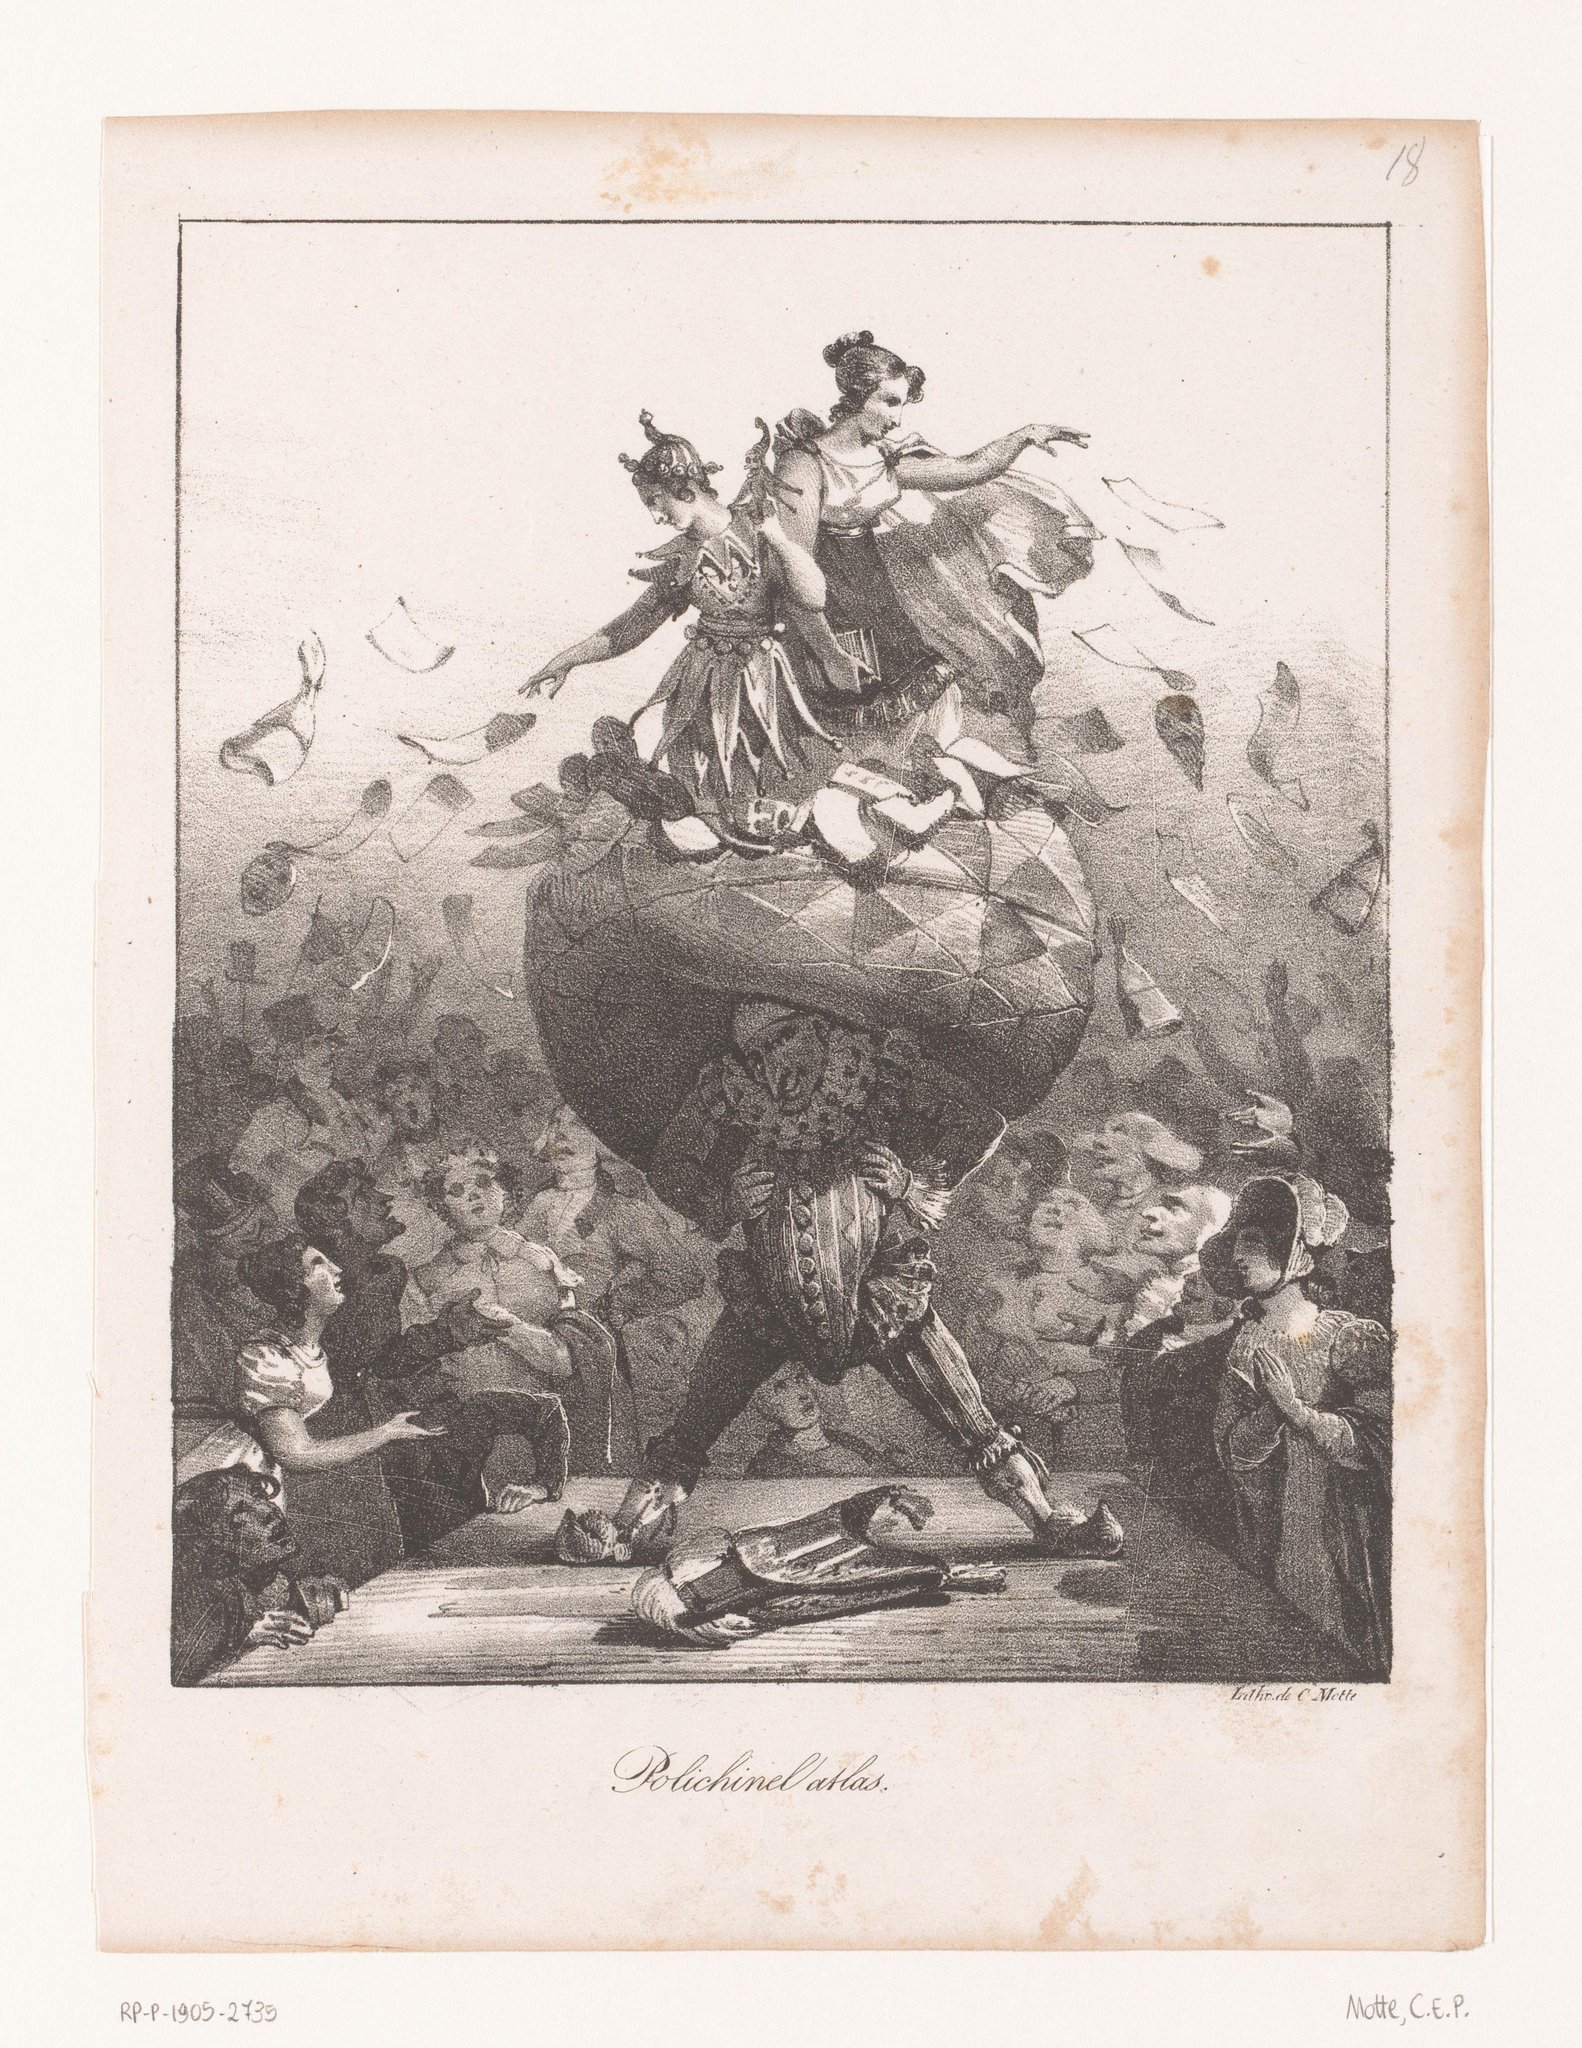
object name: print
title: Polichinel als Atlas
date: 1817-1837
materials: paper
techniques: lithograph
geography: paris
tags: (story of) atlas, circus, clown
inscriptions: collector's mark: Lugt 2228